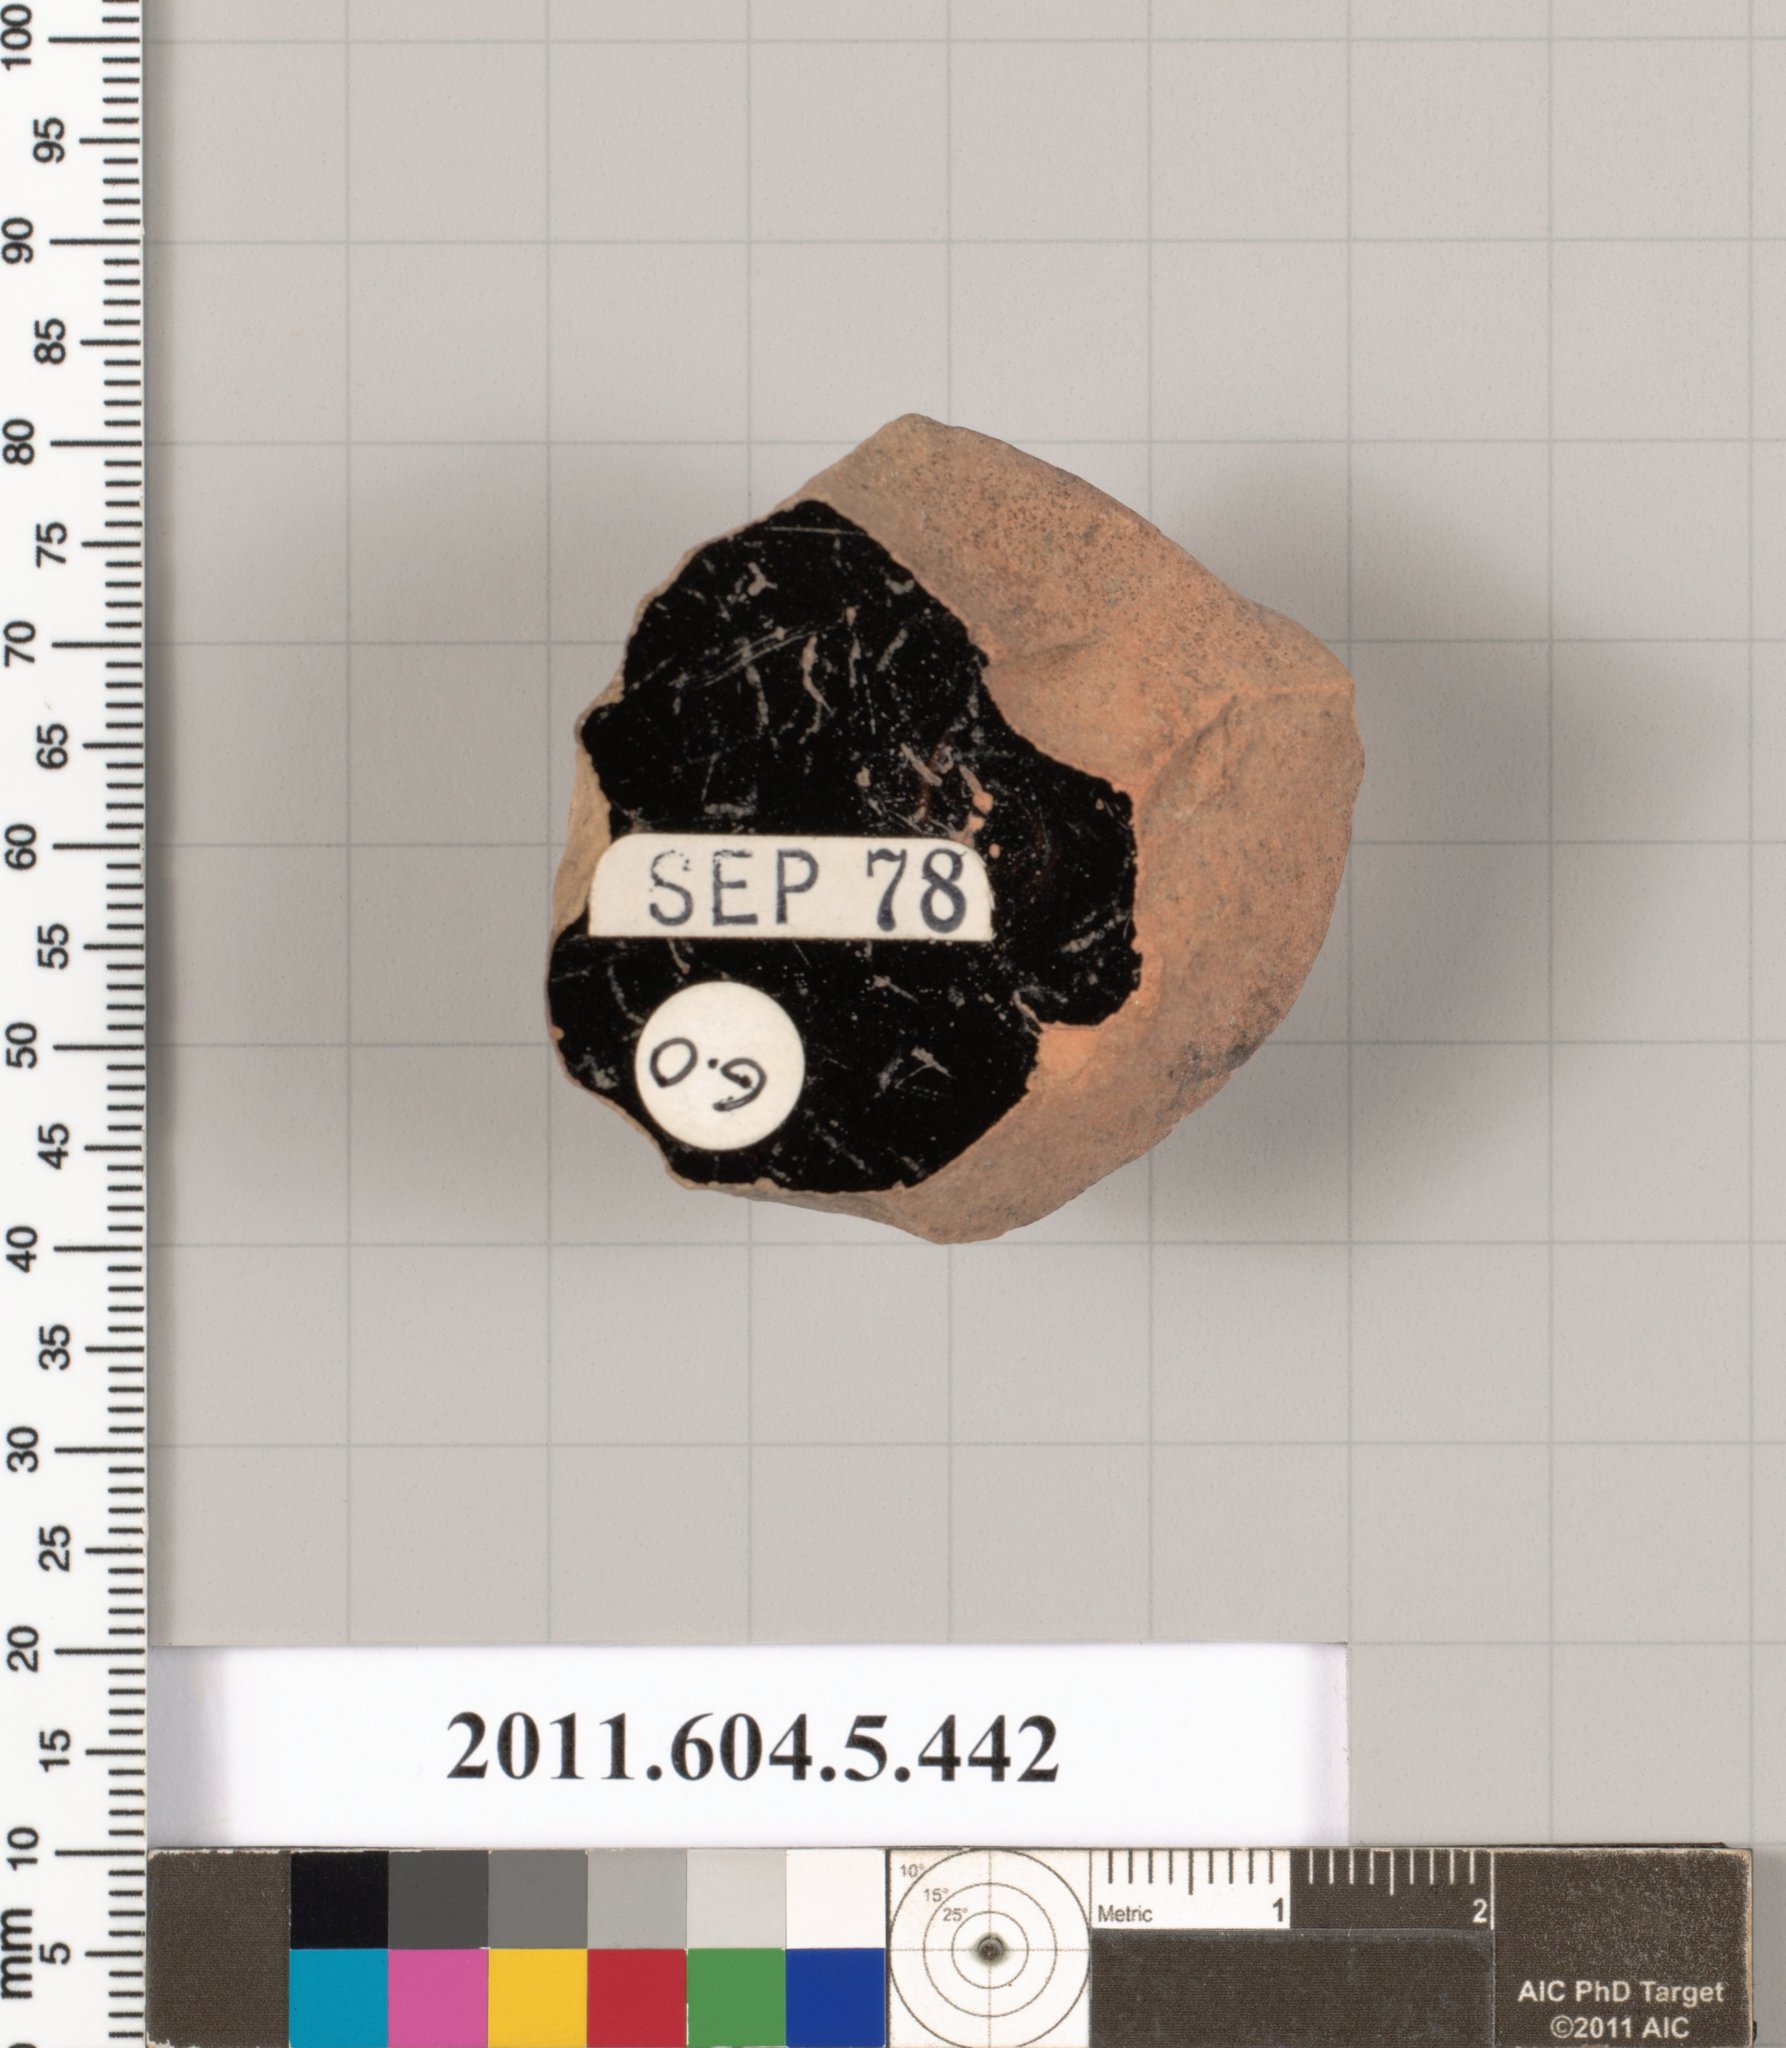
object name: kylix fragment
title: Terracotta fragment of a kylix (drinking cup)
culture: greek, attic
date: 600-401 BCE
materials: terracotta